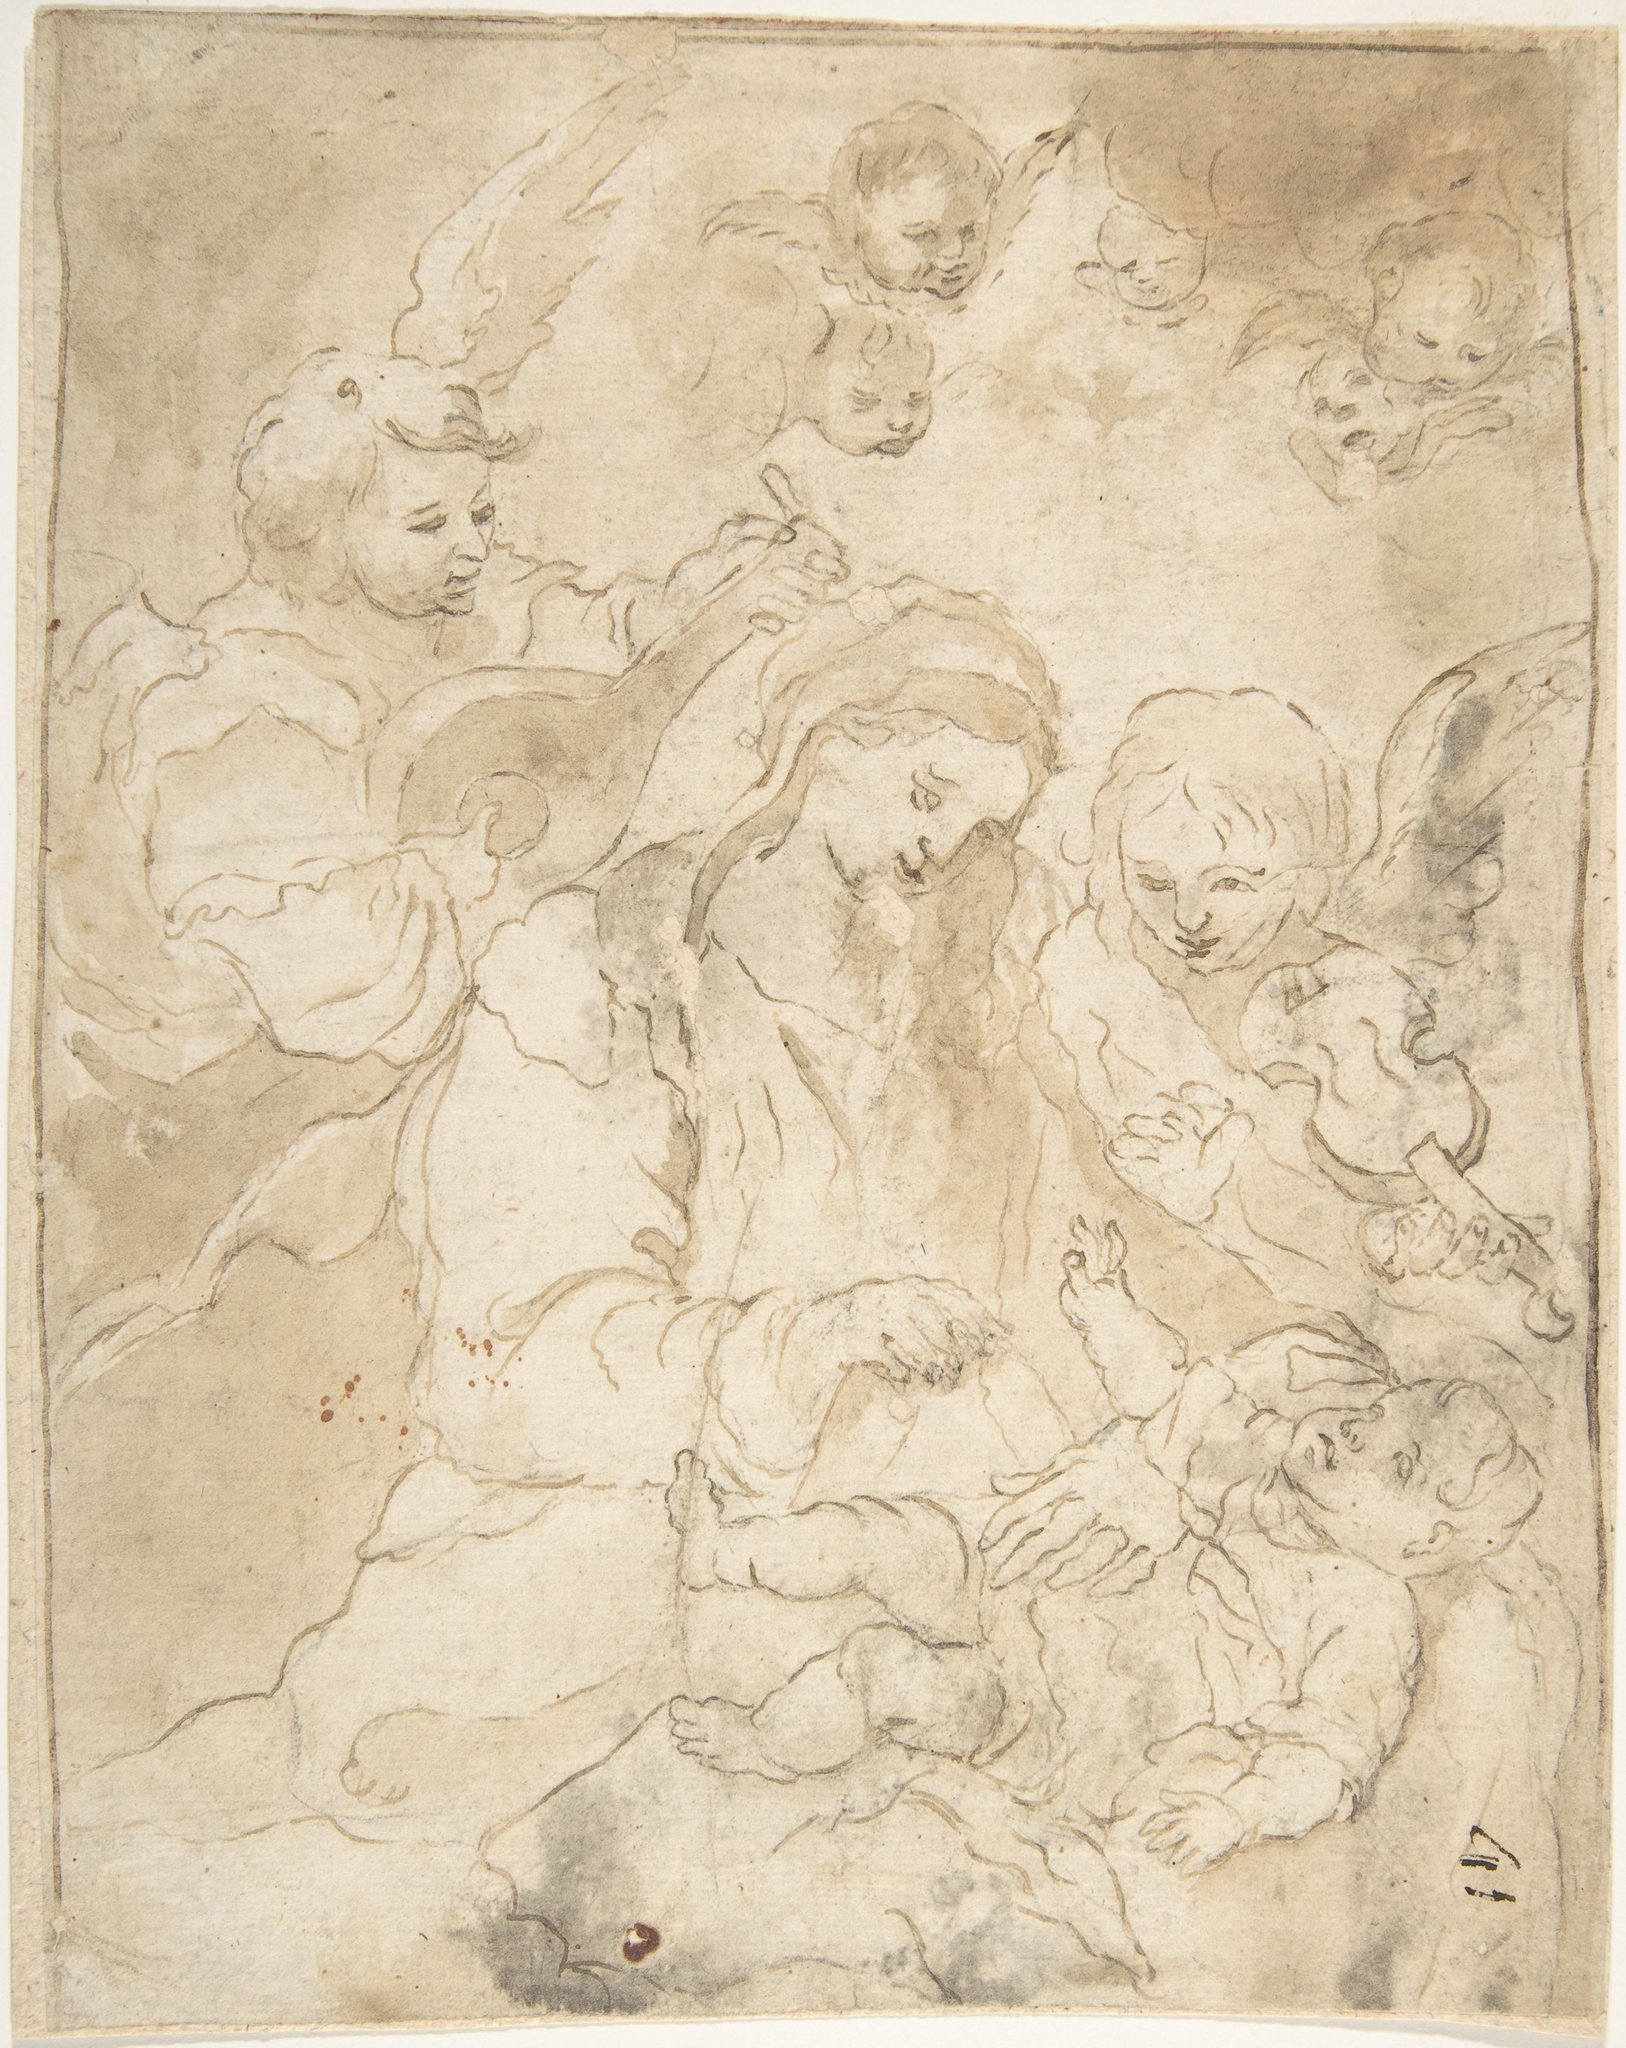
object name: drawing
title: Madonna and Child with Angels Playing Lute and Viola da Braccio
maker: anonymous, spanish, school of seville, 17th century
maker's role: artist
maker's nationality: spanish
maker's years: 1600-1700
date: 1601-1700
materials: chalk, ink, paper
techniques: brush, pen, drawing, wash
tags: lutes,violas,angels,madonna and child